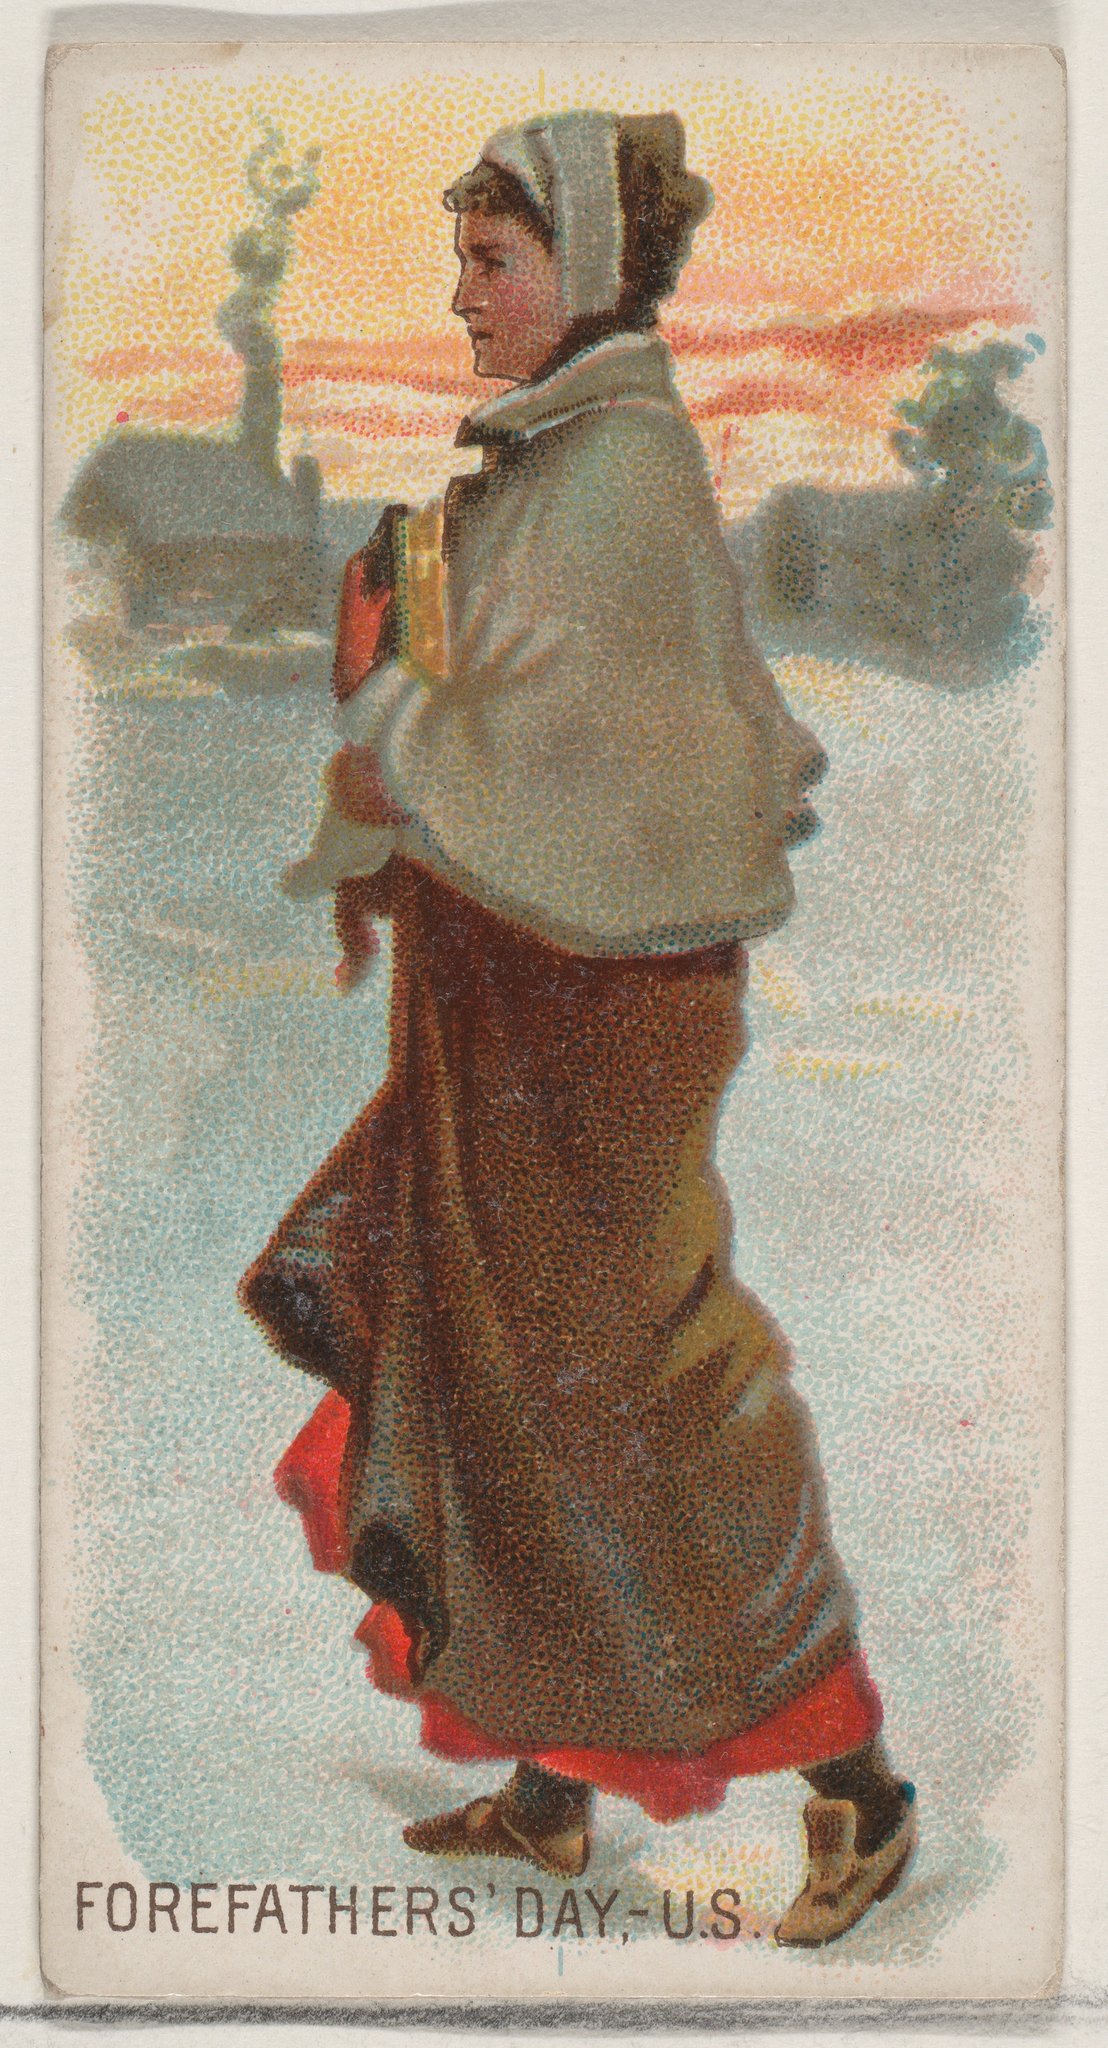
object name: print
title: Forefather's Day, United States, from the Holidays series (N80) for Duke brand cigarettes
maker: w. duke, sons & co.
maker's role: publisher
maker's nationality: american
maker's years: 1870-1920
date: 1890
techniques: color lithograph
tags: women